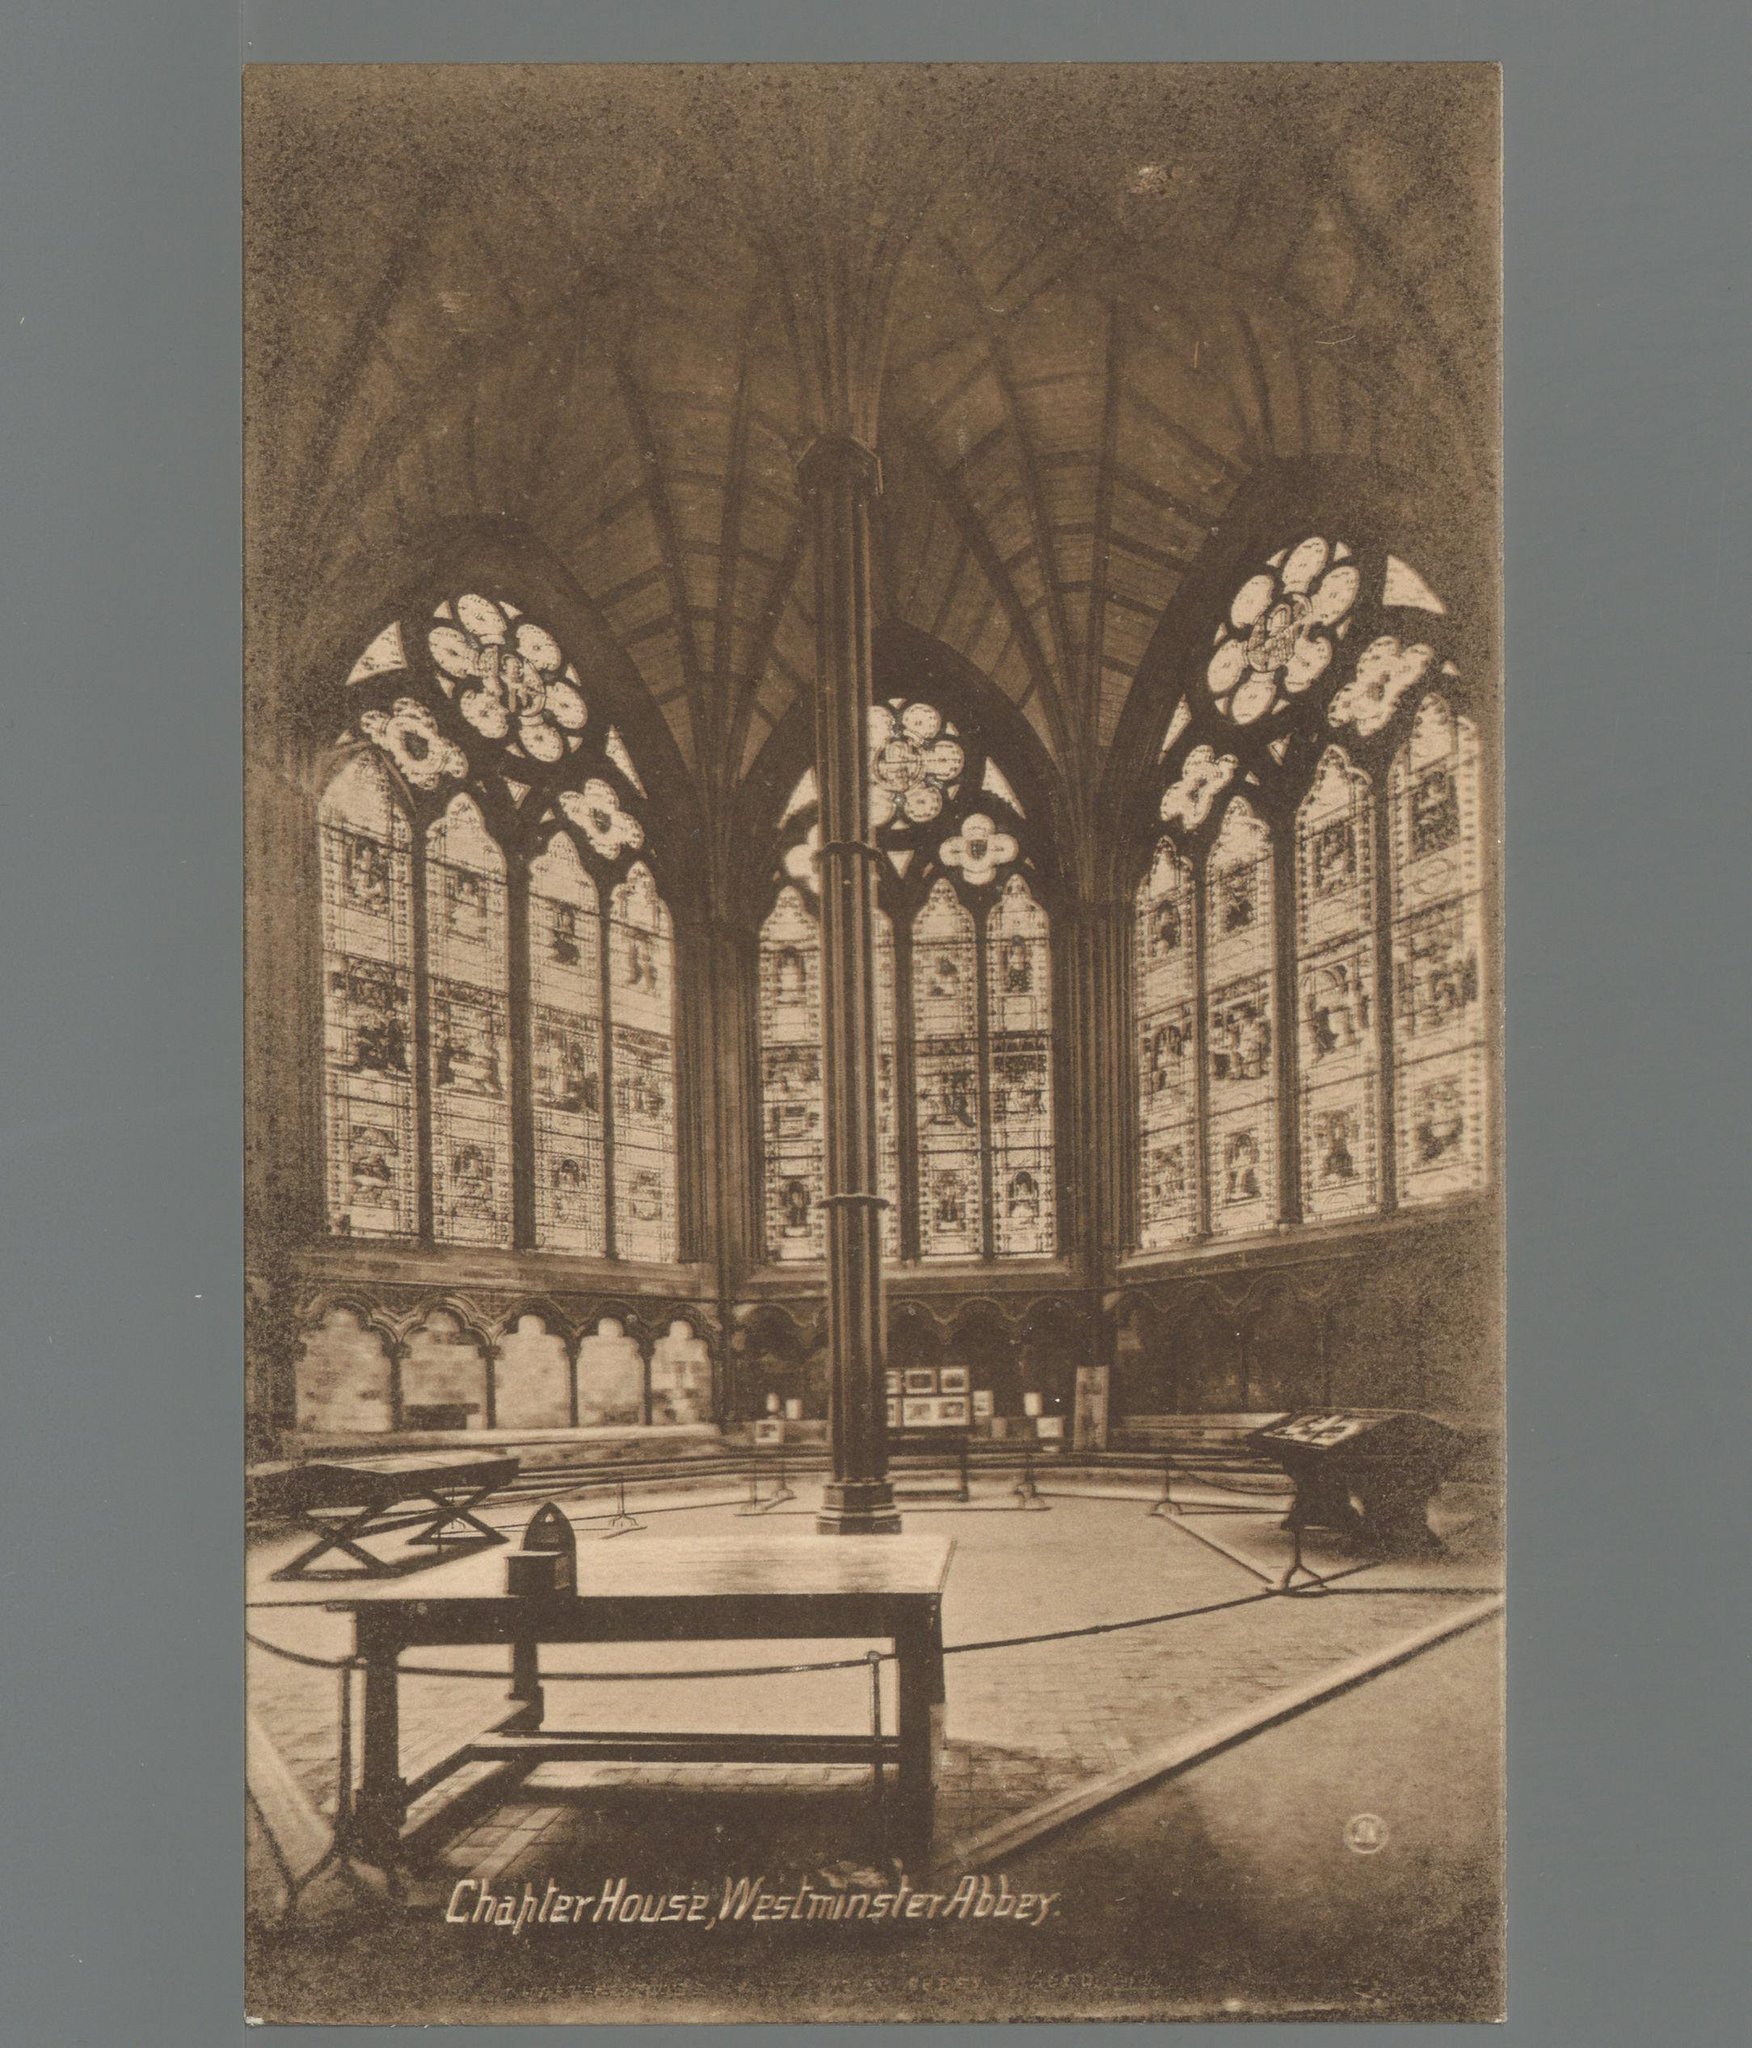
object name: ansichtkaart, prentbriefkaart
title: Chapter House, Westminster Abbey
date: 1902-1930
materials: cardboard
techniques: photograph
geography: great britain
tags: interior of church, westminster abbey